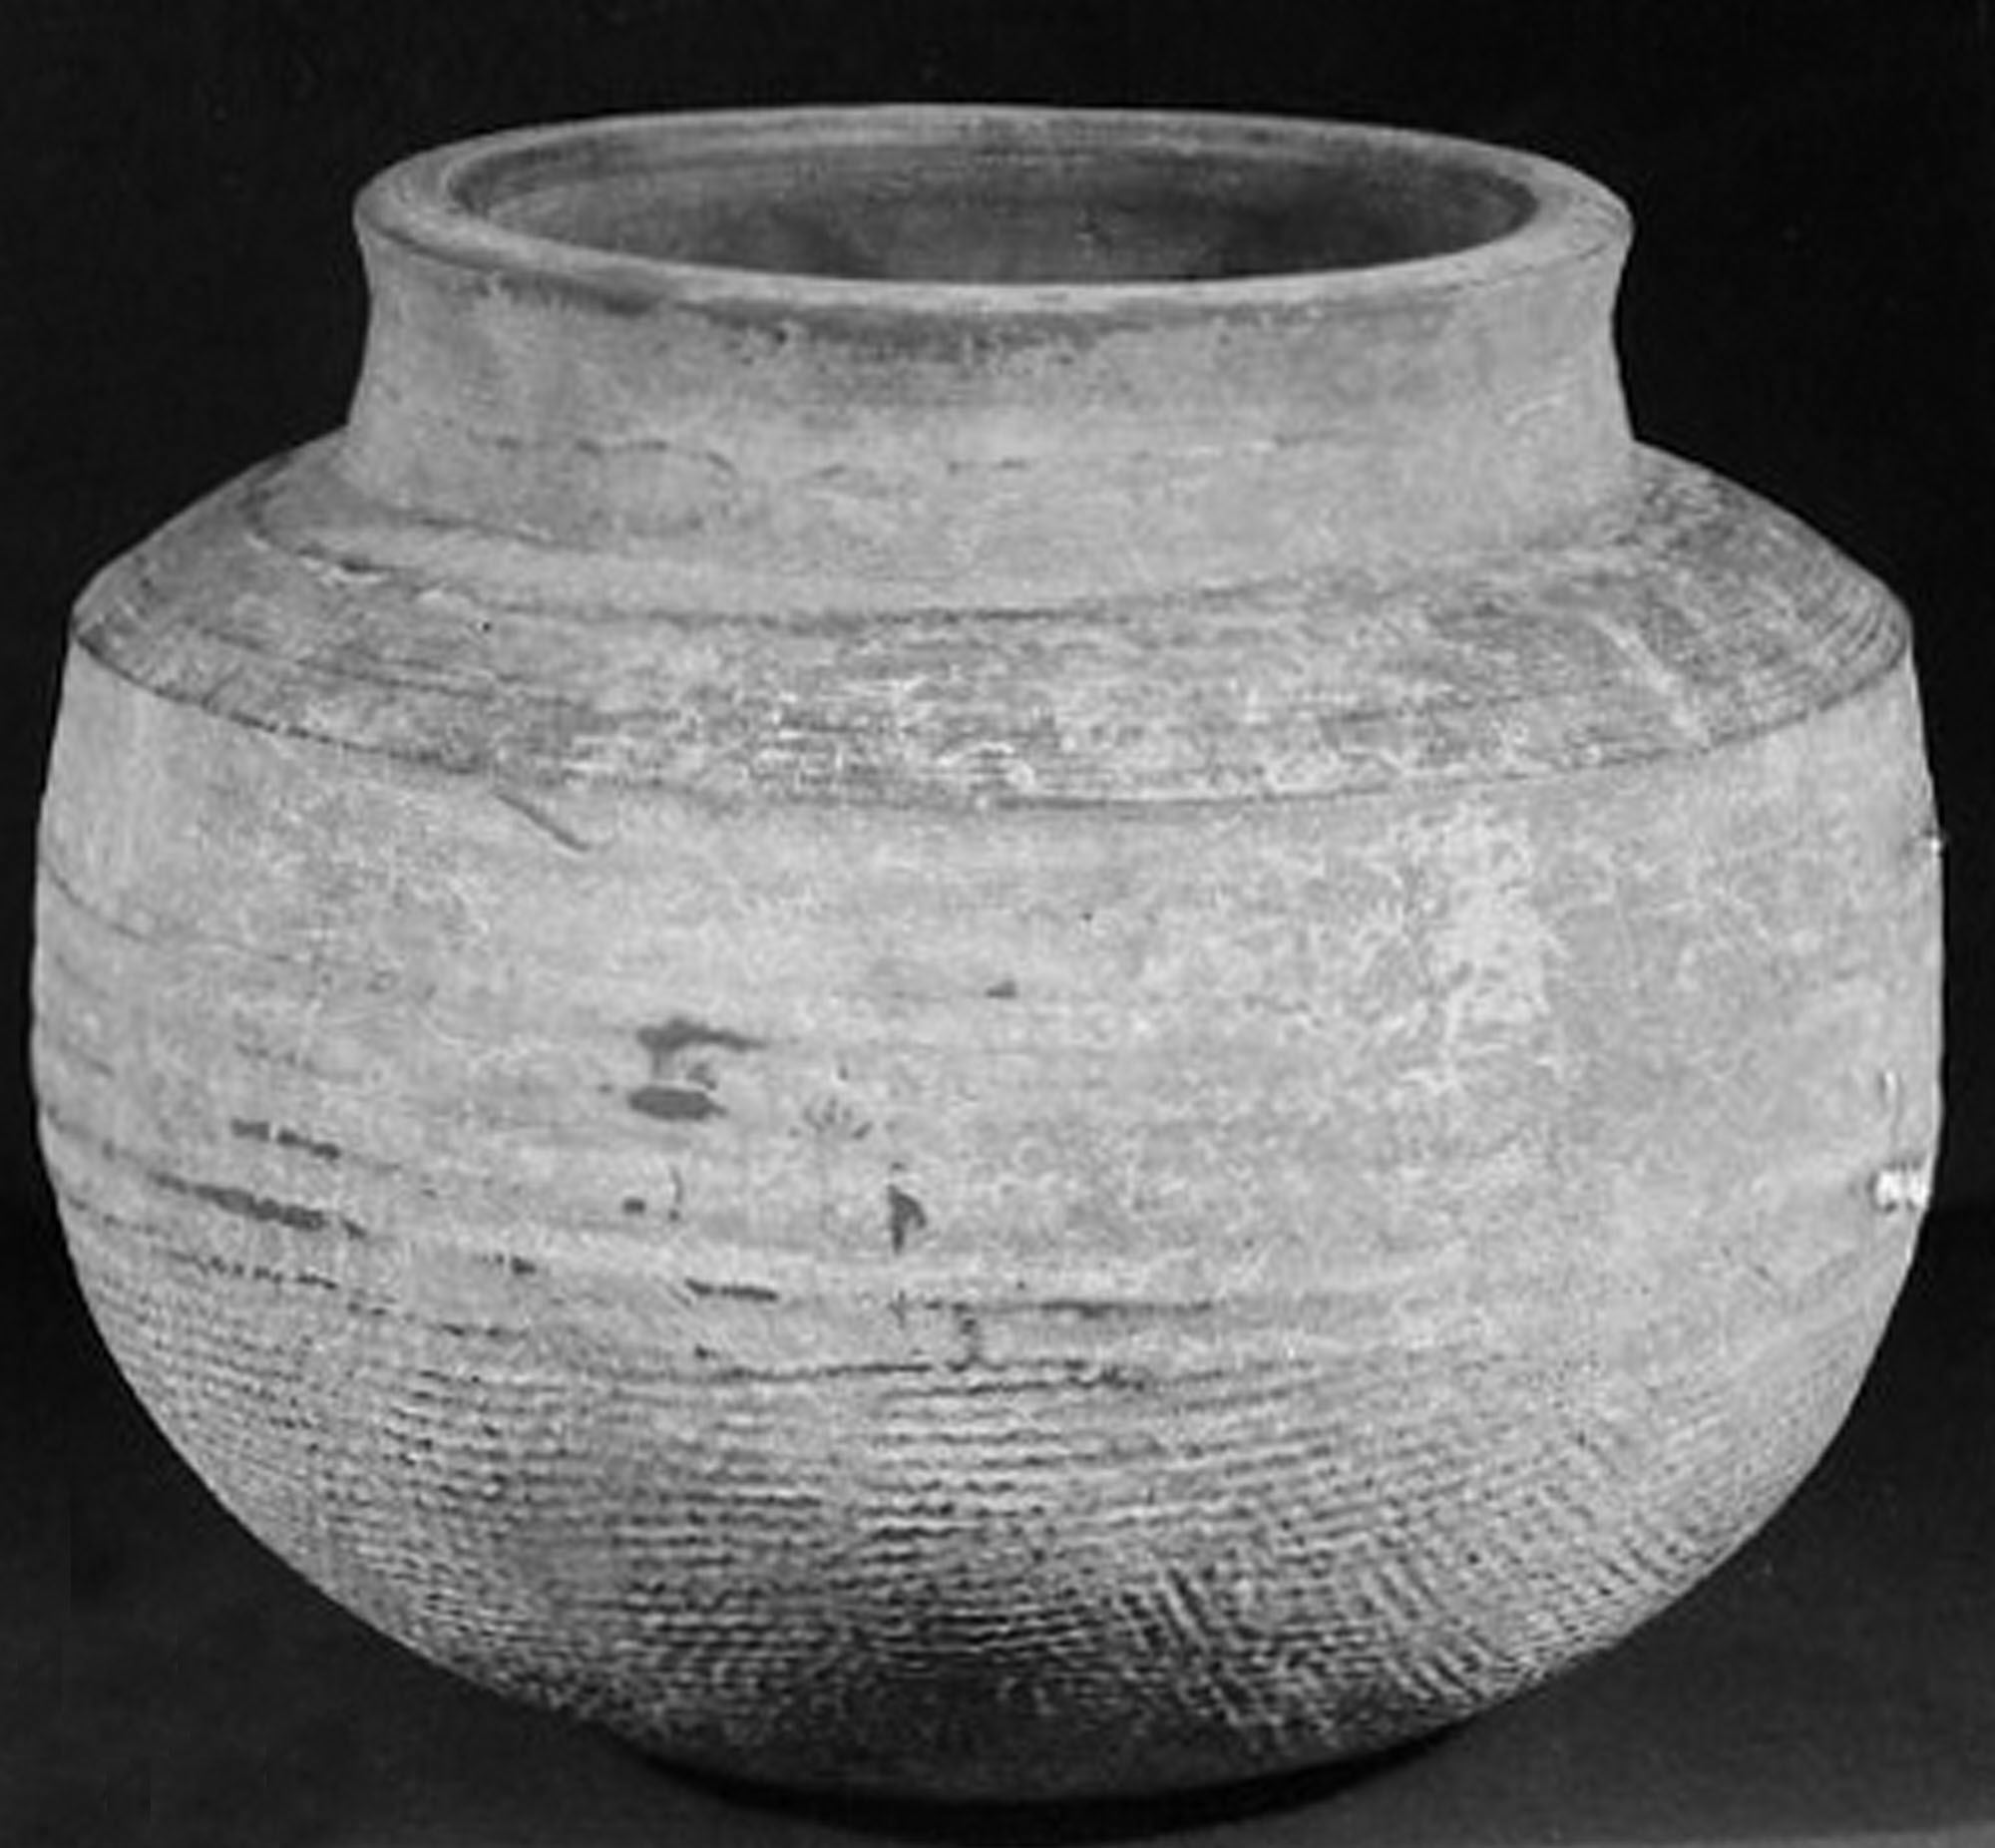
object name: jar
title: Jar (Guan)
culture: chinese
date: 500-201 BCE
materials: cord, earthenware